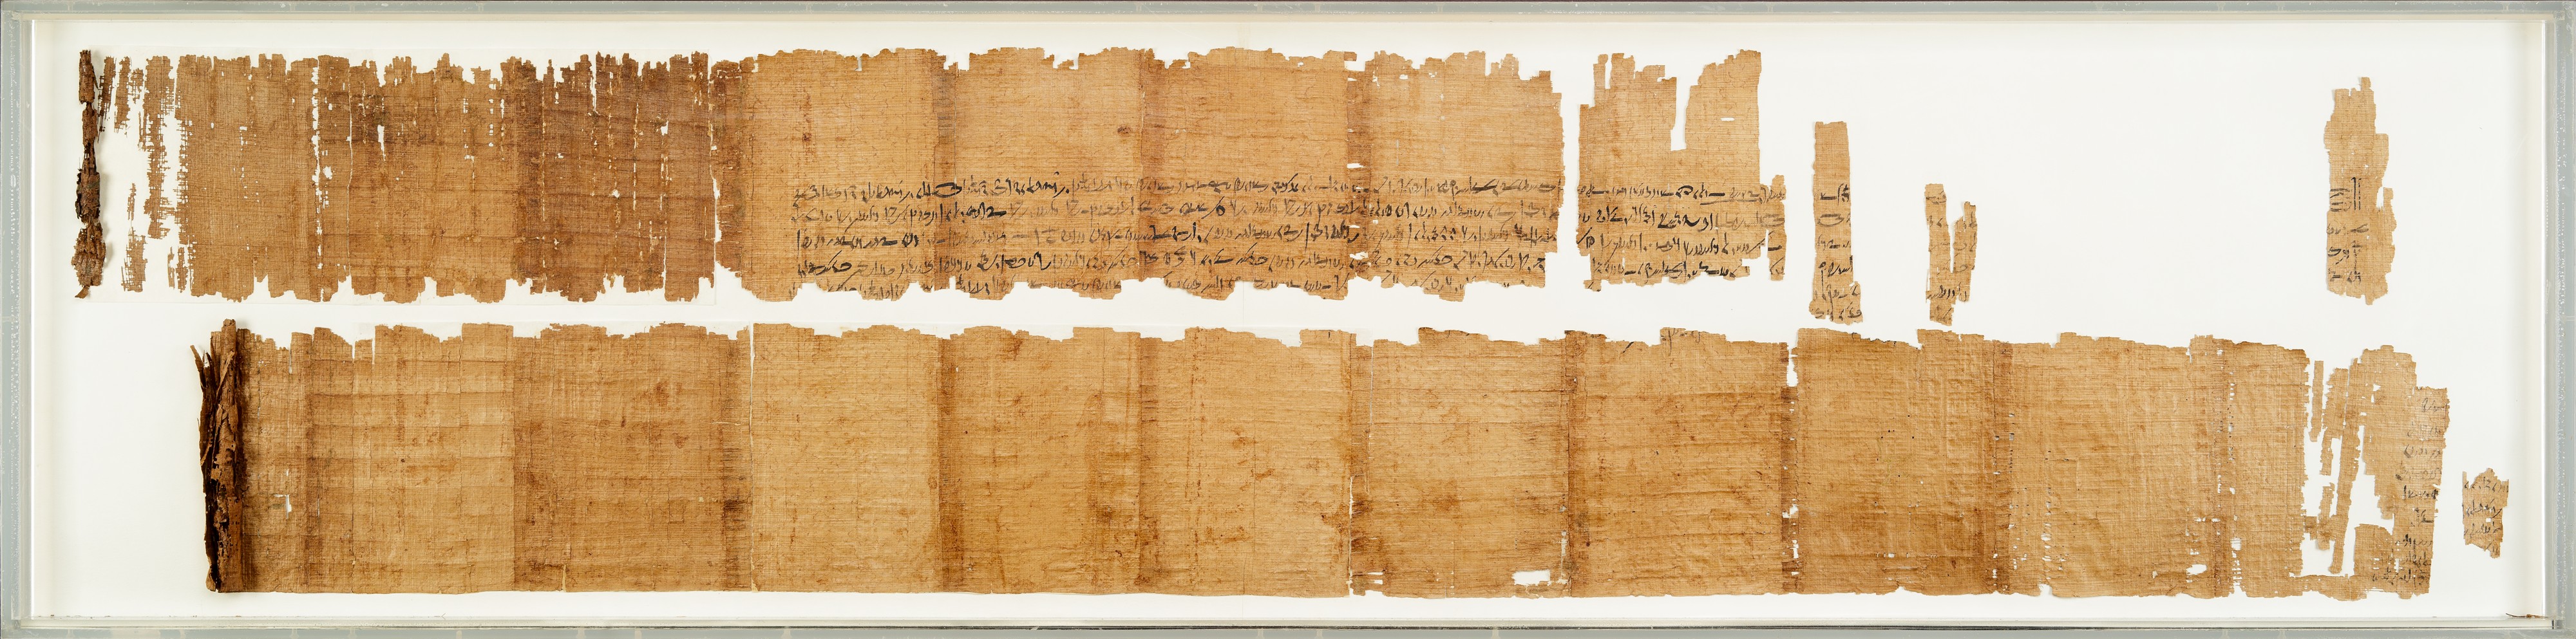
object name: manuscript, marriage contract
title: Marriage Contract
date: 380-343 BCE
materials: ink, papyrus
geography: egypt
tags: documents,demotic